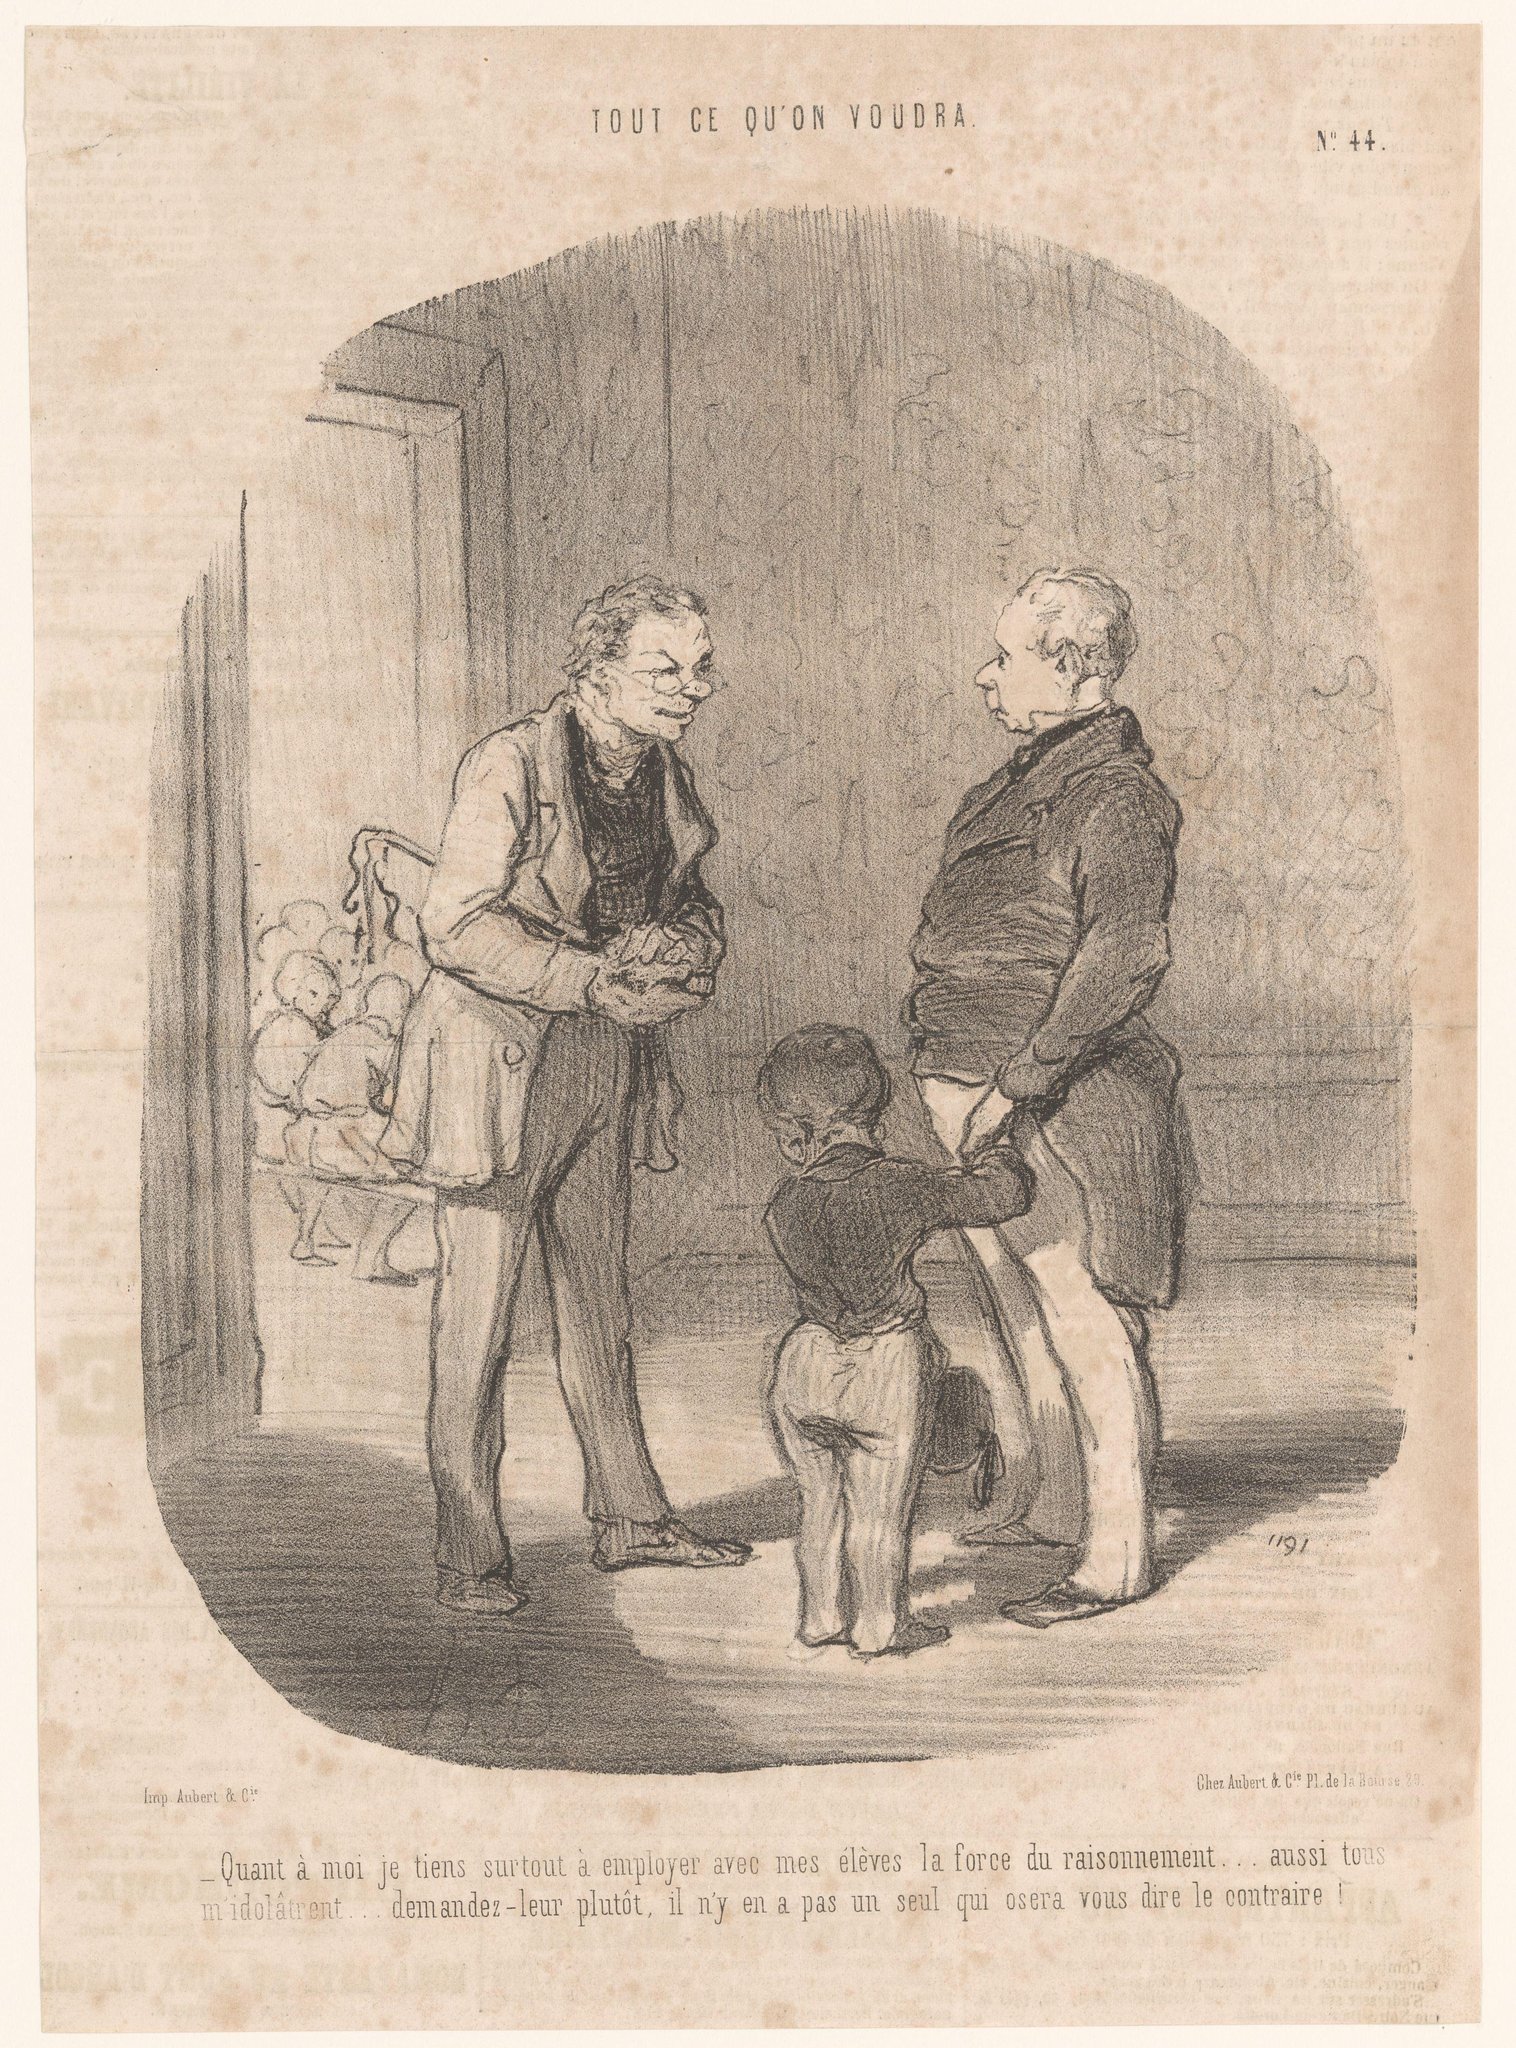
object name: cartoon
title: Leerkracht met zweep prijst zichzelf aan bij een vader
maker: honoré daumier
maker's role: draughtsman, painter, print maker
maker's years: 1808-1879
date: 1848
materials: paper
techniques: lithograph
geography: paris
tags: caricatures (human types), teacher and pupil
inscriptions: collector's mark: Lugt 2228a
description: Prent gebruikt voor: Le Charivari, 27 mei 1848.